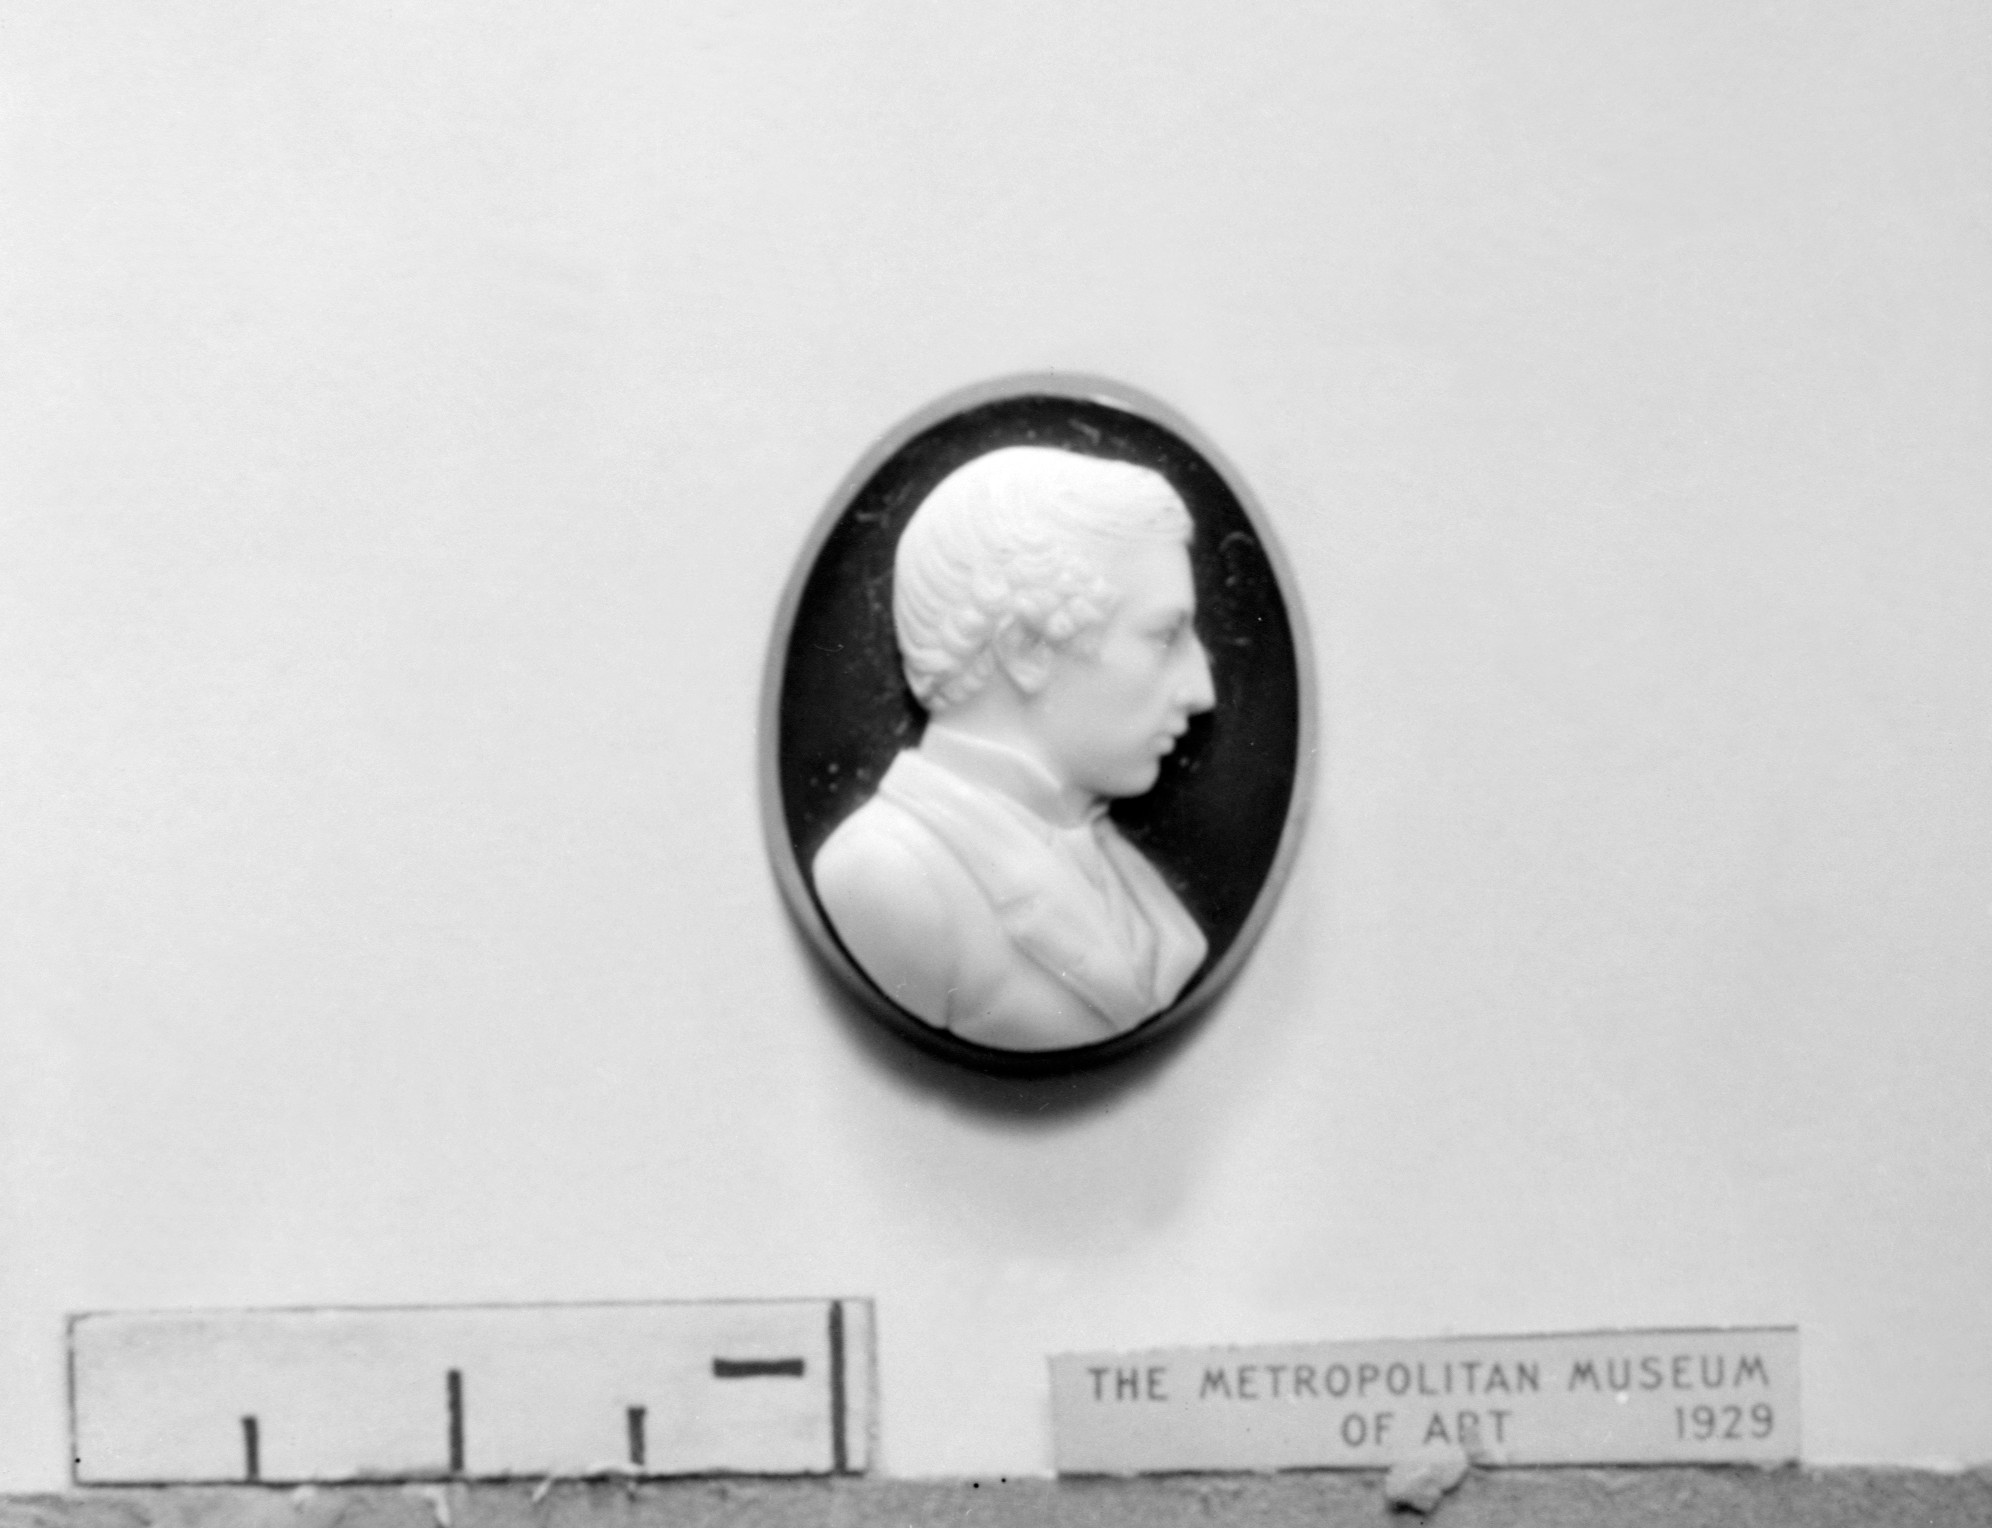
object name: cameo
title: The Prince Imperial (Son of Napoleon III)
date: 1875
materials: onyx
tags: men,profiles